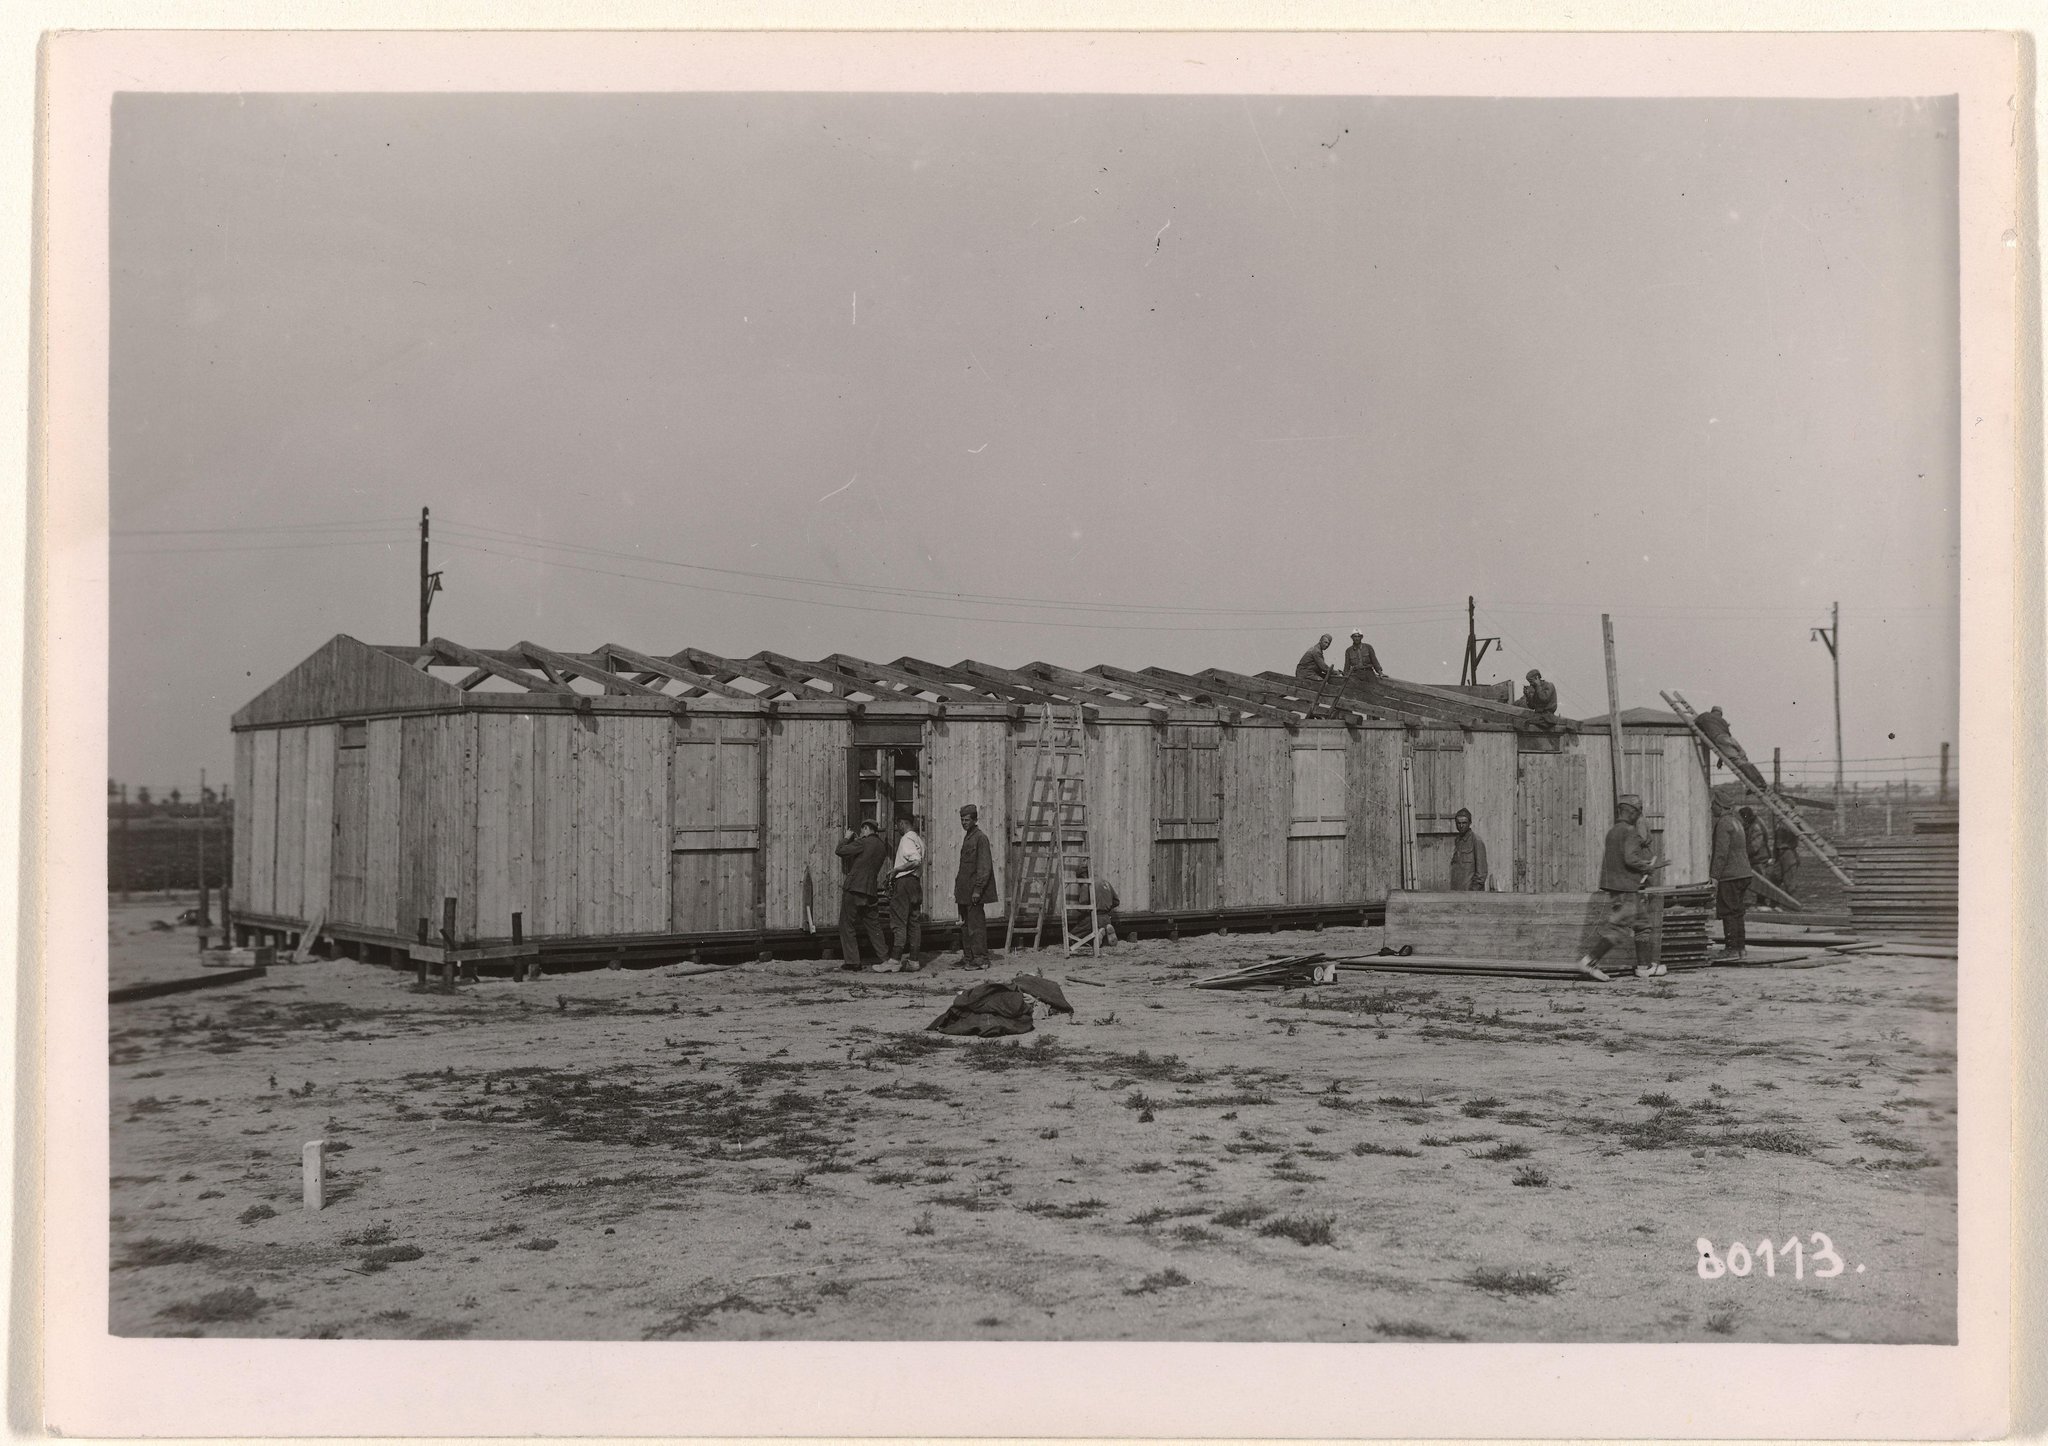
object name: photograph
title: Bouw van een barak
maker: dick w.b. van maarseveen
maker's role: fotograaf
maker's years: 1905-1990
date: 1943-1945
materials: photographic support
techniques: gelatin silver print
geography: muhlberg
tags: the hague, dick w.b. van maarseveen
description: De bouw van een barak door Franse krijgsgevangenen. Onderdeel van een groep foto's gemaakt door Dick van Maarseveen in het Duitse krijgsgevangenenkamp Stalag IV B in Mühlberg in de periode 1943-1945.